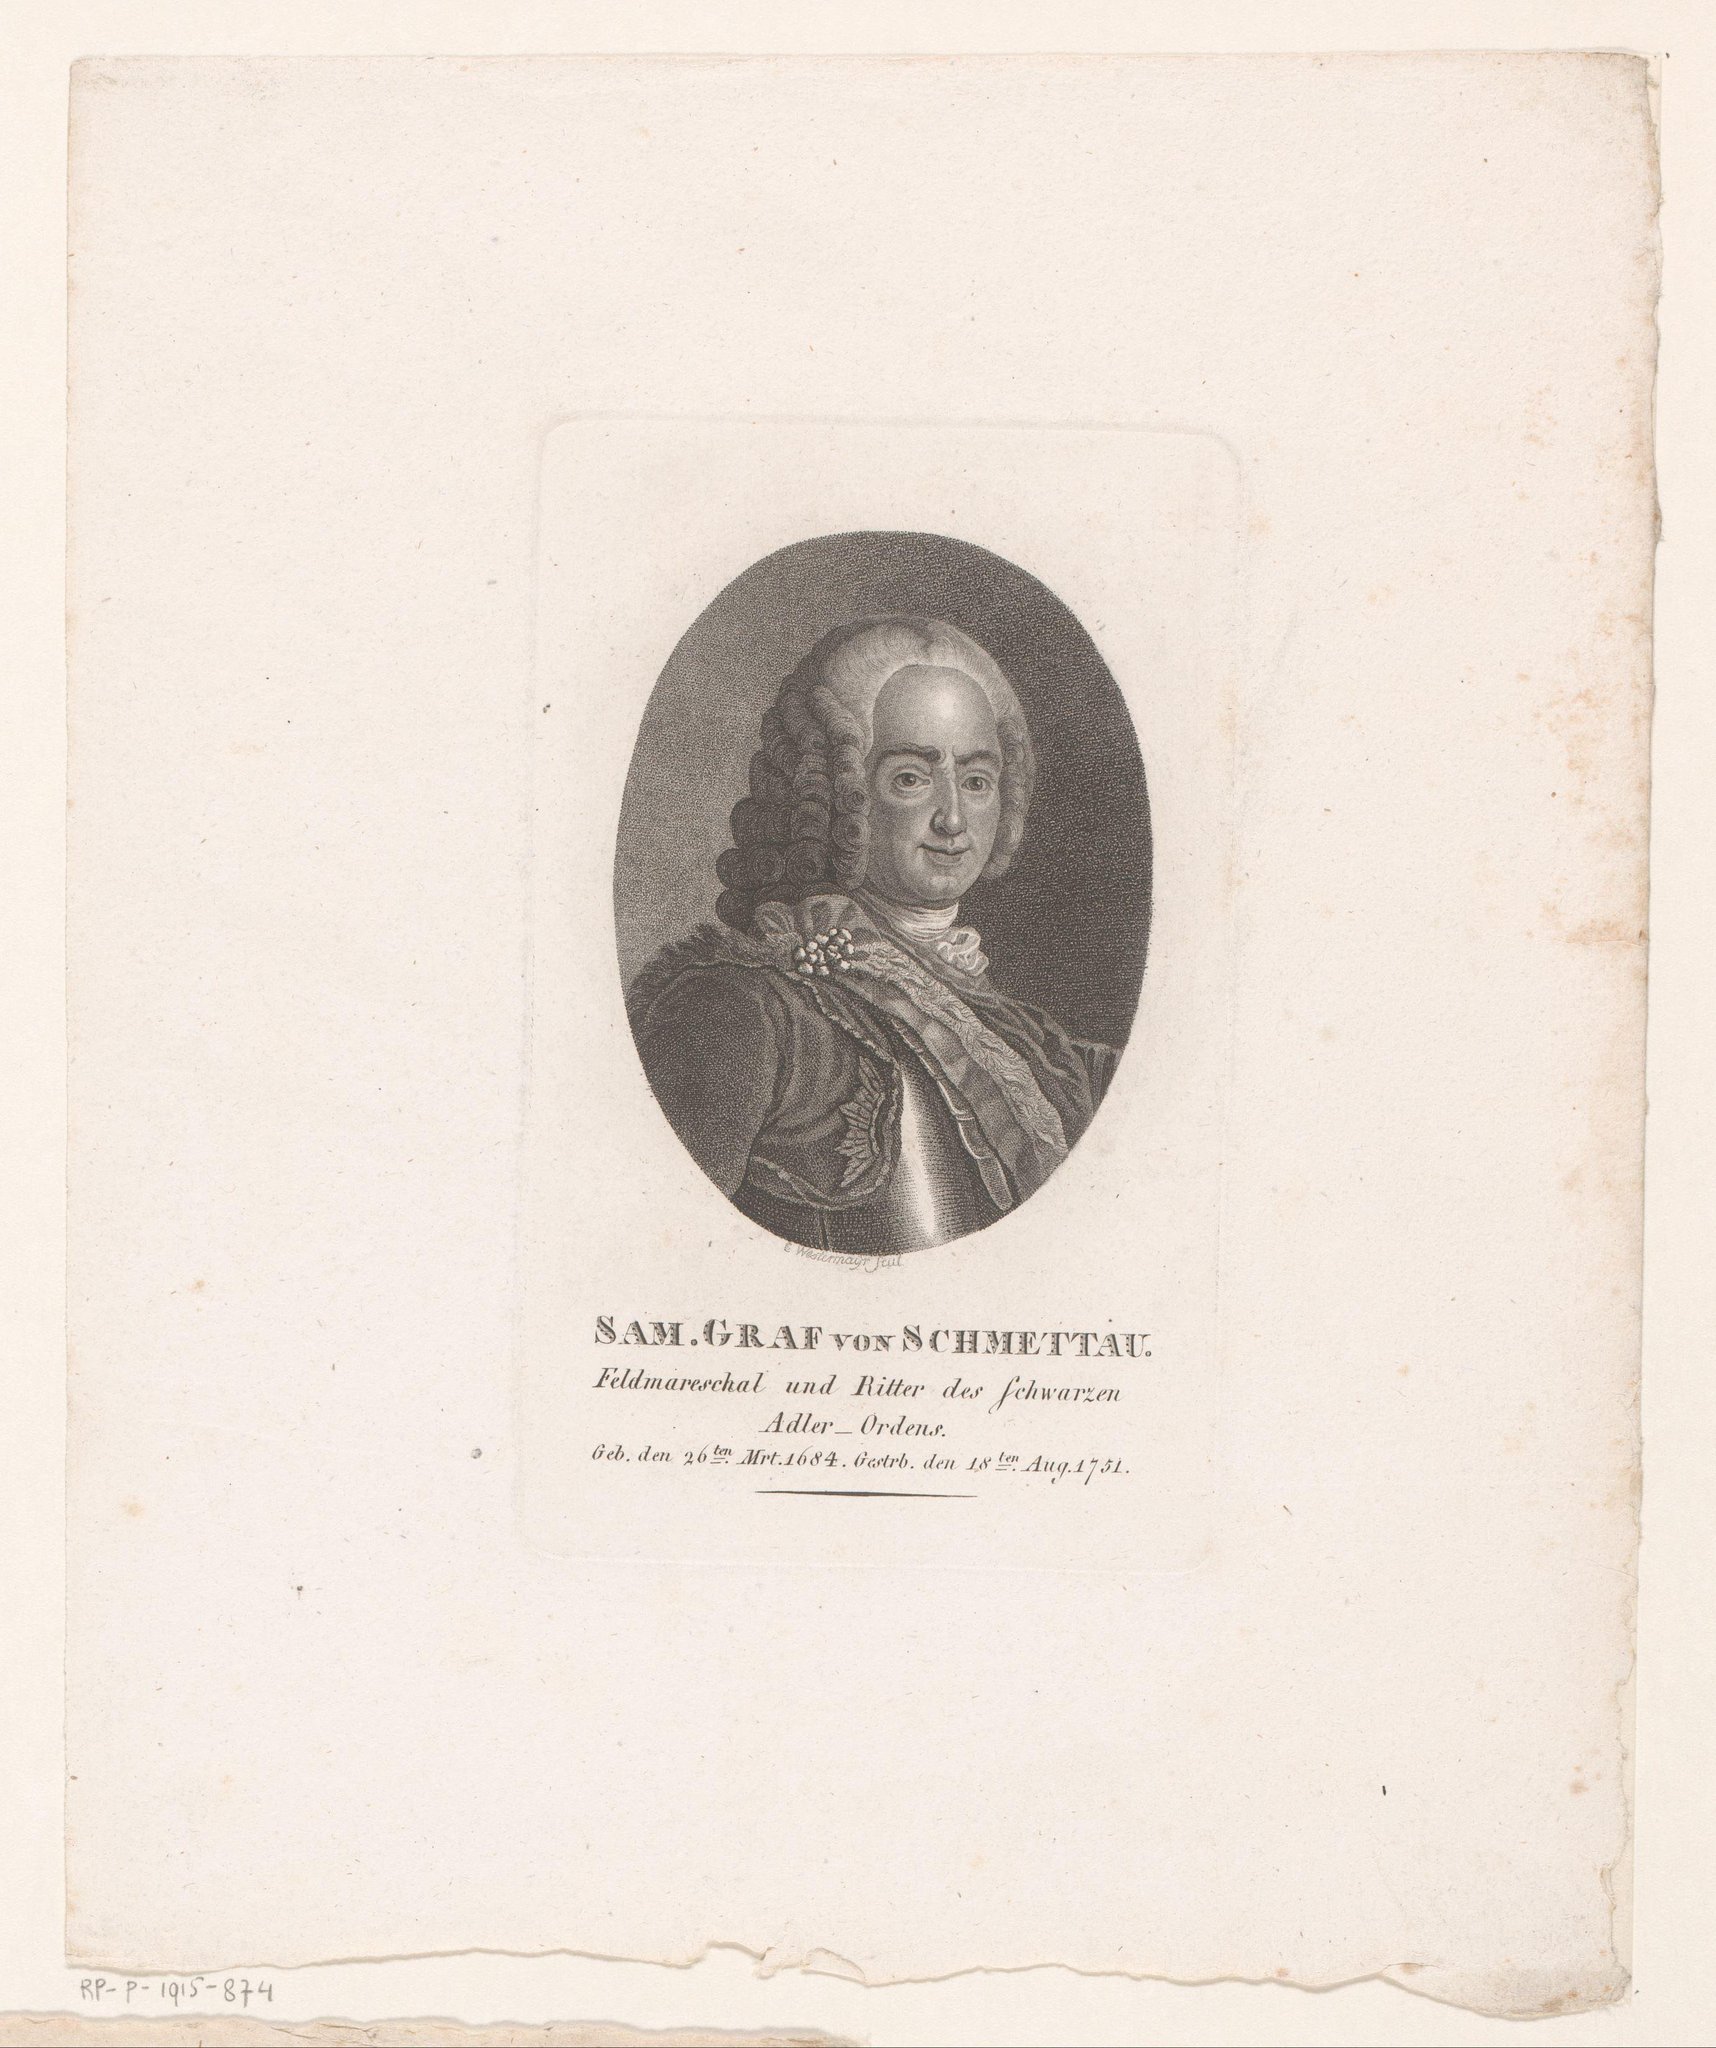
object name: print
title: Portret van Samuel von Schmettau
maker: konrad westermayr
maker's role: print maker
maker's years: 1765-1834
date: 1775-1834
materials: paper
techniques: engraving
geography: germany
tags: berlin, historical persons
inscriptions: collector's mark: Lugt 2228